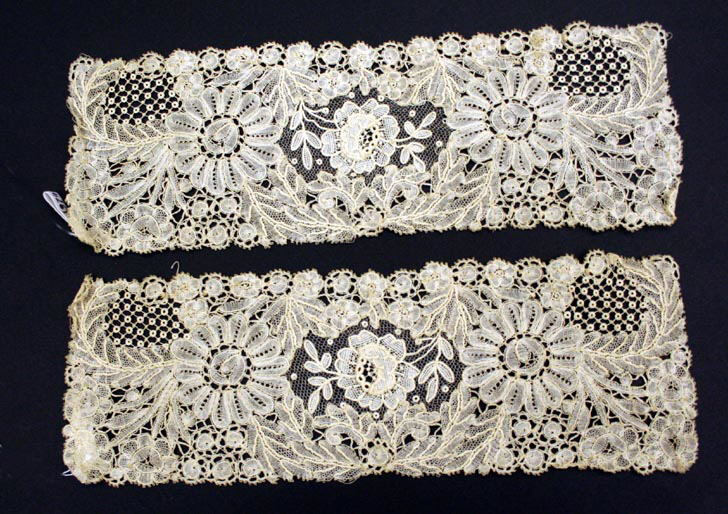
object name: cuff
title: Cuffs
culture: belgian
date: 1867-1900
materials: linen